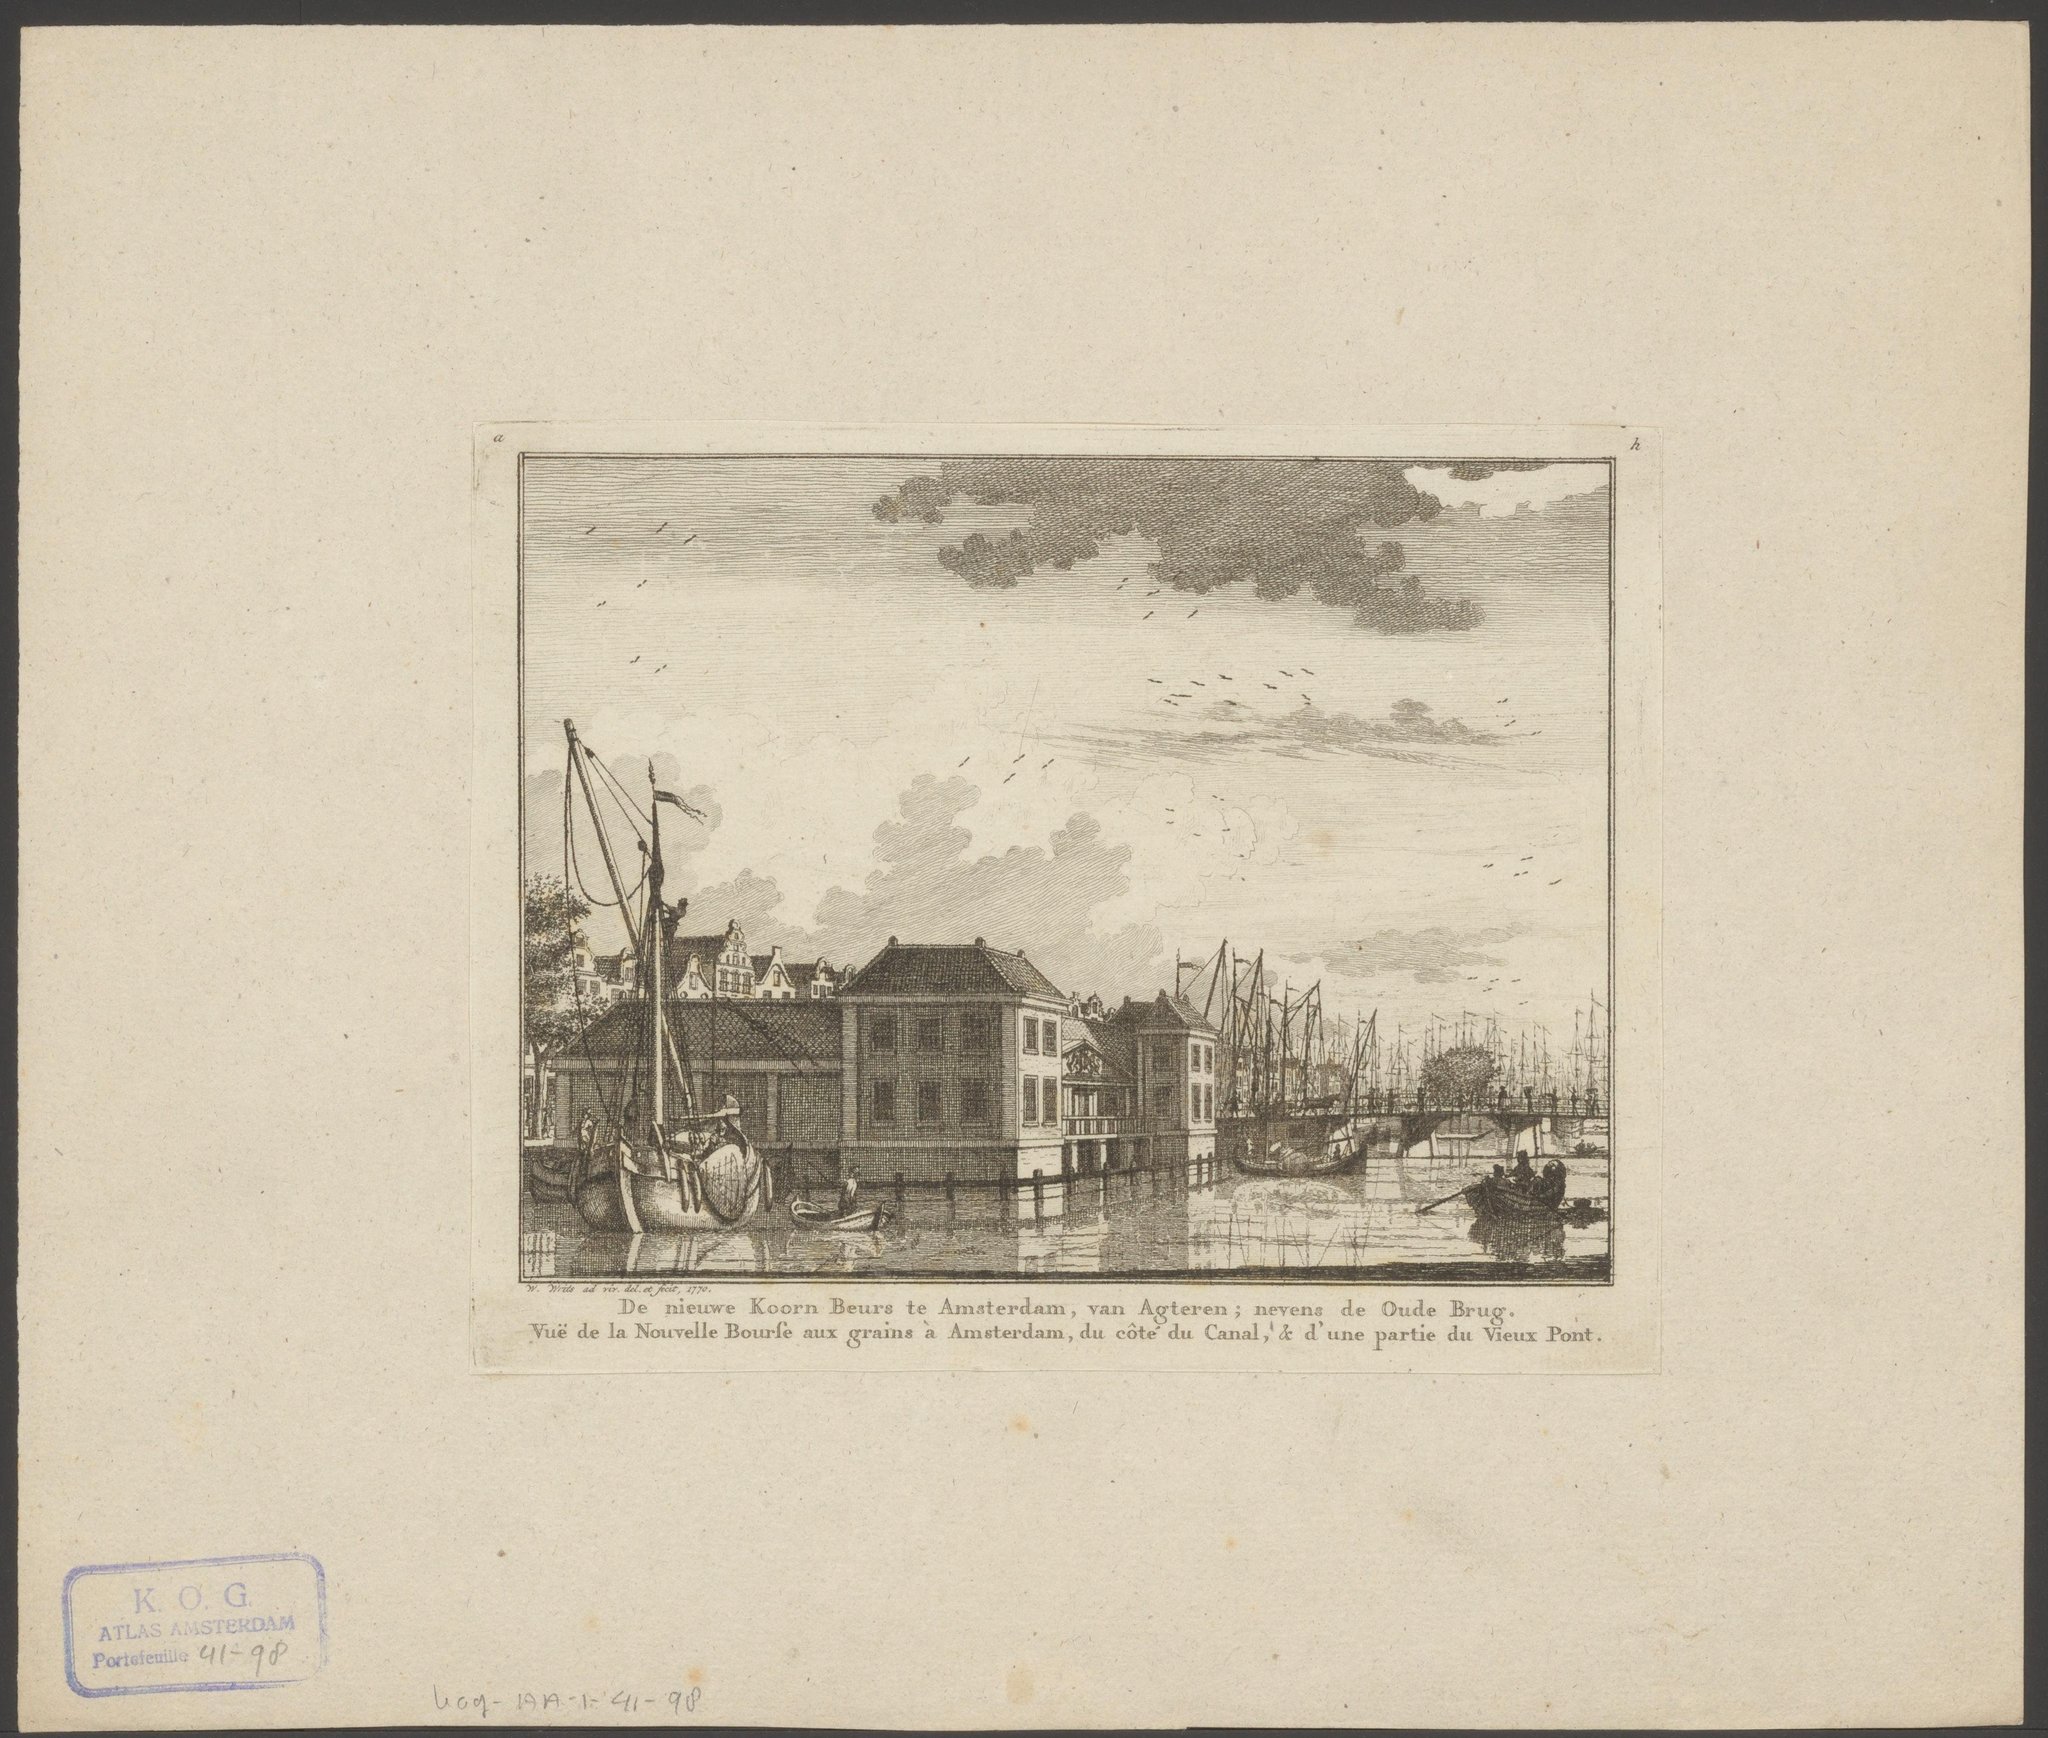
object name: print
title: De nieuwe Koorn Beurs te Amsterdam, van agteren; nevens de Oude Brug / Vuë de la Nouvelle Bourse aux grains à Amsterdam, du côté du canal, & d'une partie du Vieux Pont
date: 1770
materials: paper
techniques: etching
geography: amsterdam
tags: sailing-ship, sailing-boat, bridge in city across river, canal, etc., market-hall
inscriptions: collector's mark: ‘41-98’ Lugt 1641b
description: De prent werd eerst in 1770 uitgegeven door onder anderen Reinier Ottens en Pieter Yver, als onderdeel van een serie stadsgezichten: de 'Atlas van de stad Amsterdam; of Afbeelding der voornaamste gezichten, gebouwen, oudheeden en historien van Amsterdam (...)'. Deze serie, begonnen in 1769, bevatte prenten met tekstuele toelichting die konden worden ingebonden in verschillende publicaties over Amsterdam. De prent werd ook nog gebruikt in: Atlas van de waereldberoemde koopstad Amsteldam (...). Amsterdam: Jan Barend Elwe, 1804. Latere staat, genummerd rechtsboven met pl. 2, gebruikt in publicatie uit 1824.